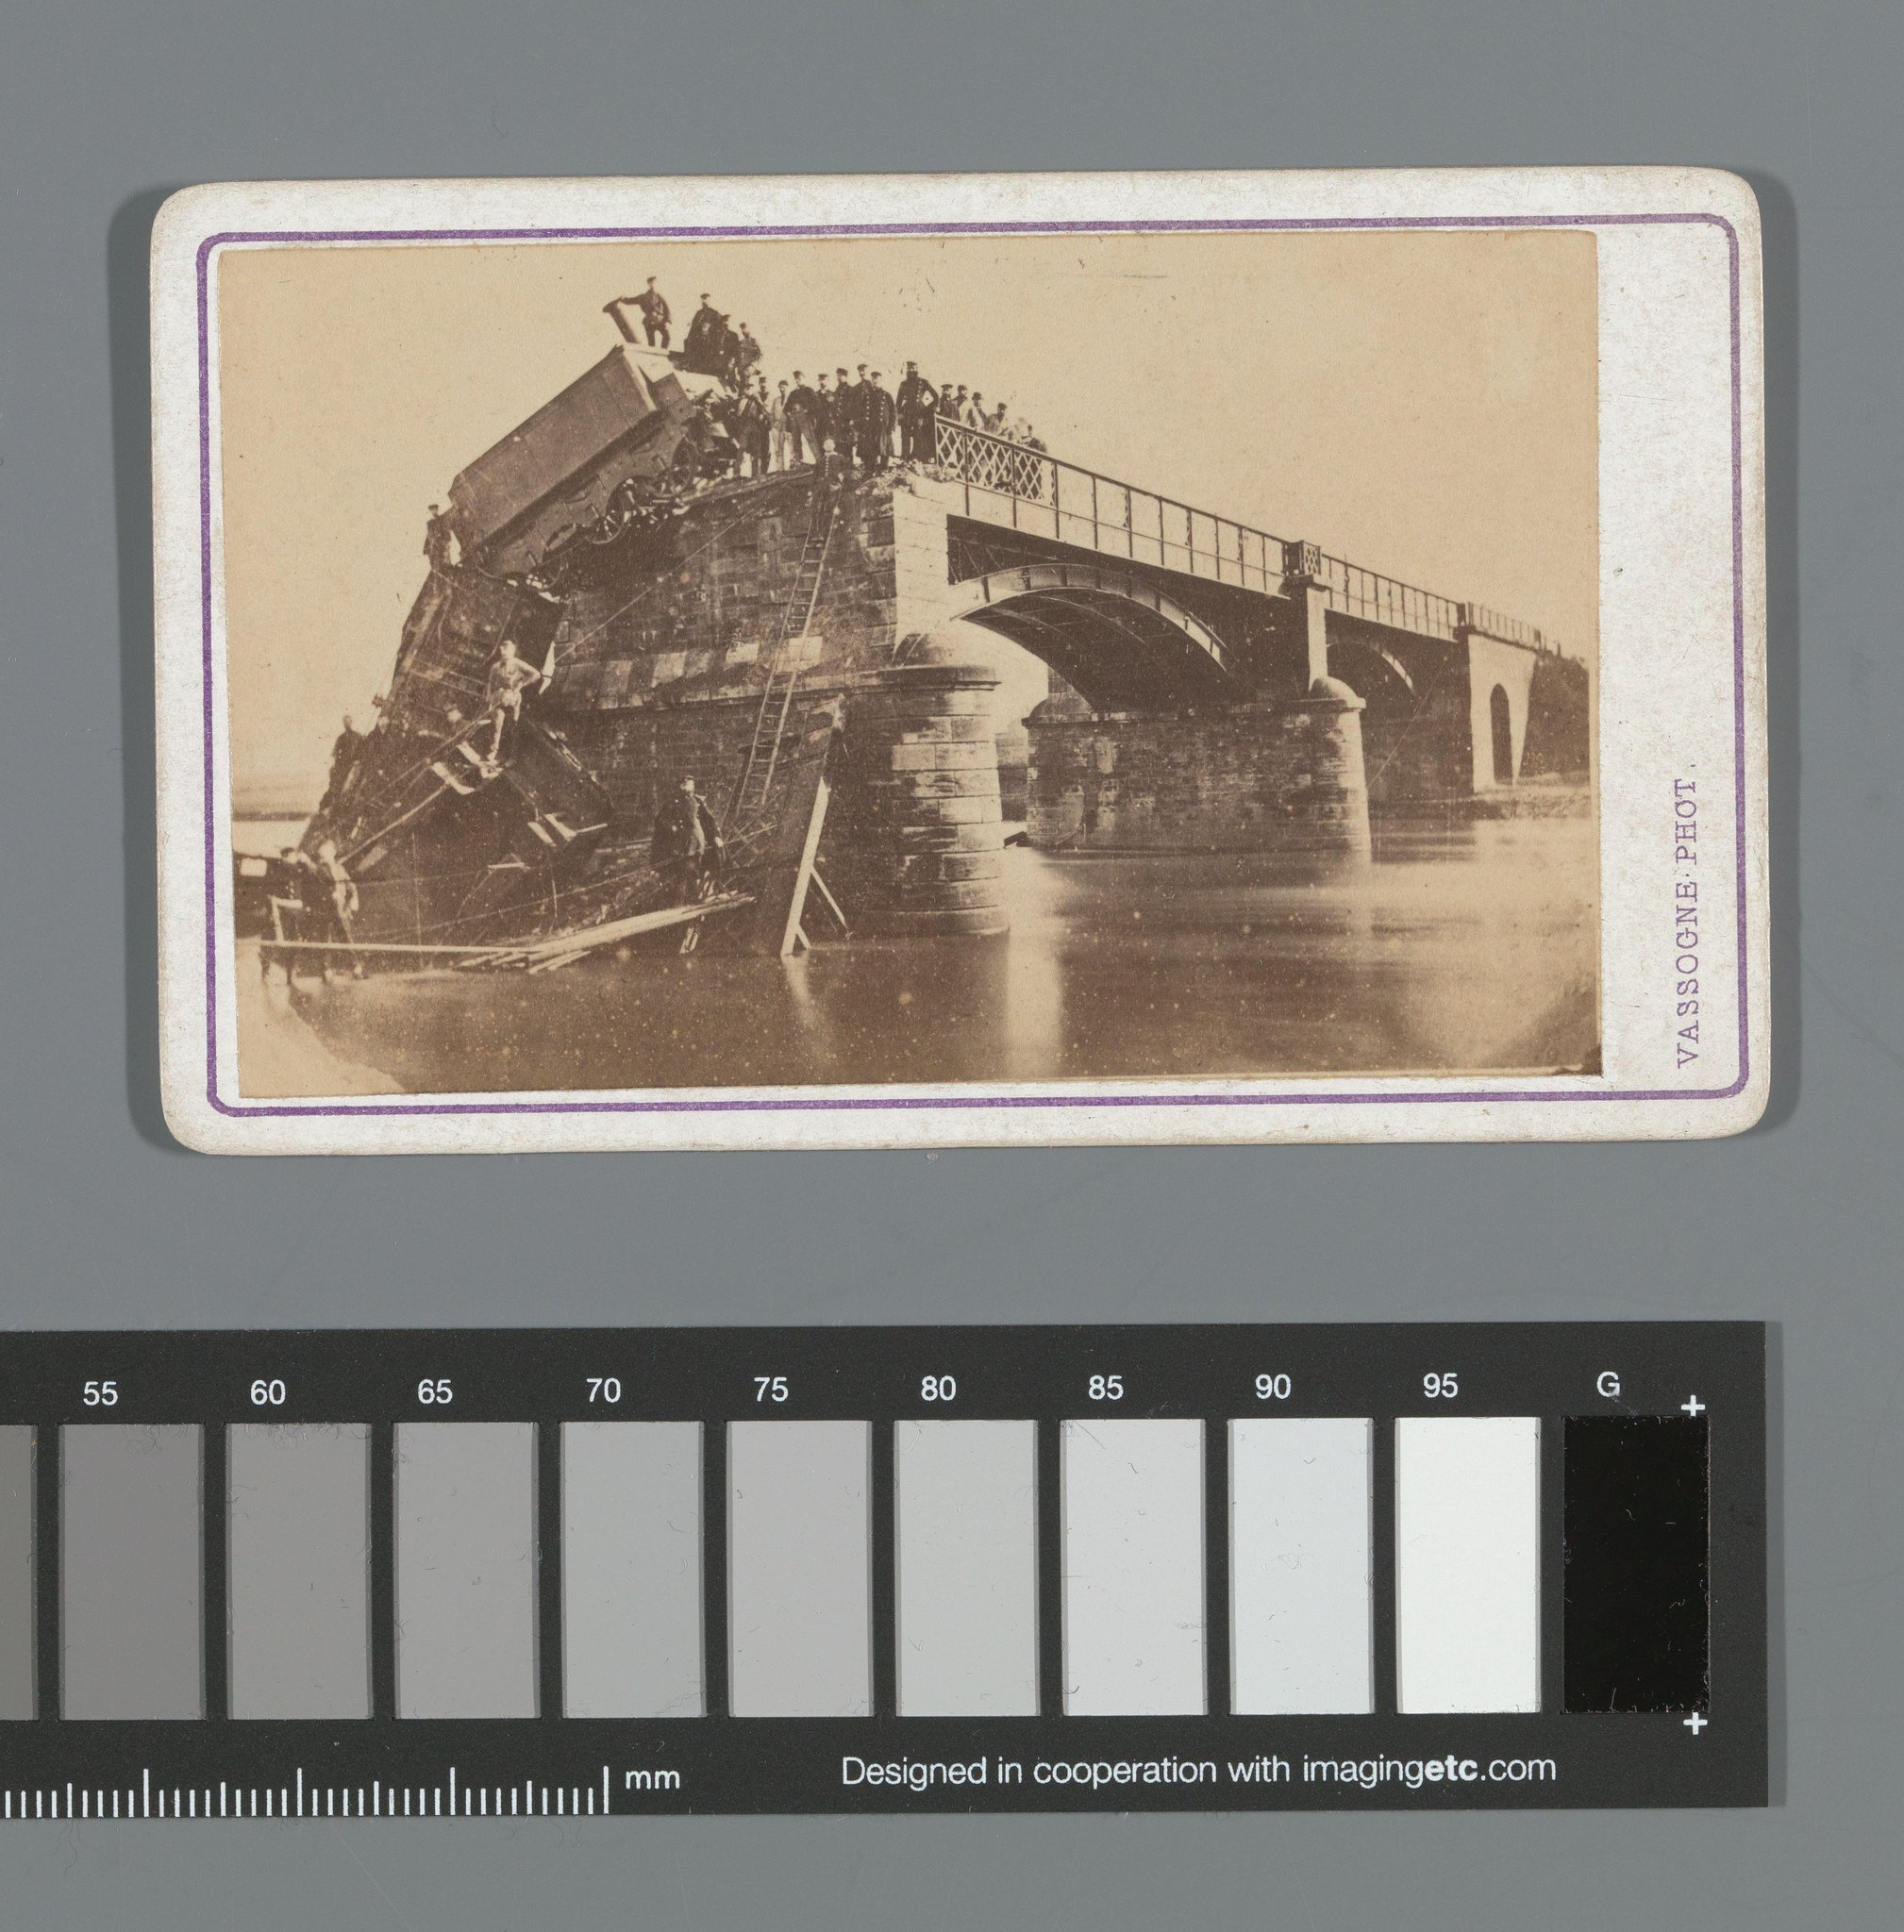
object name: carte de visite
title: Duitse locomotief op de brug bij Le Theux, kapotgeschoten tijdens de Frans-Duitse oorlog van 1870-71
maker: louis eugène vassogne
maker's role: fotograaf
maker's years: 1836-1881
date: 1870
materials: cardboard, paper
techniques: albumen print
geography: le theux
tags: accident with locomotive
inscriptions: address: ‘95, Sous les Allée, 95,/ CHARLEVILLE’